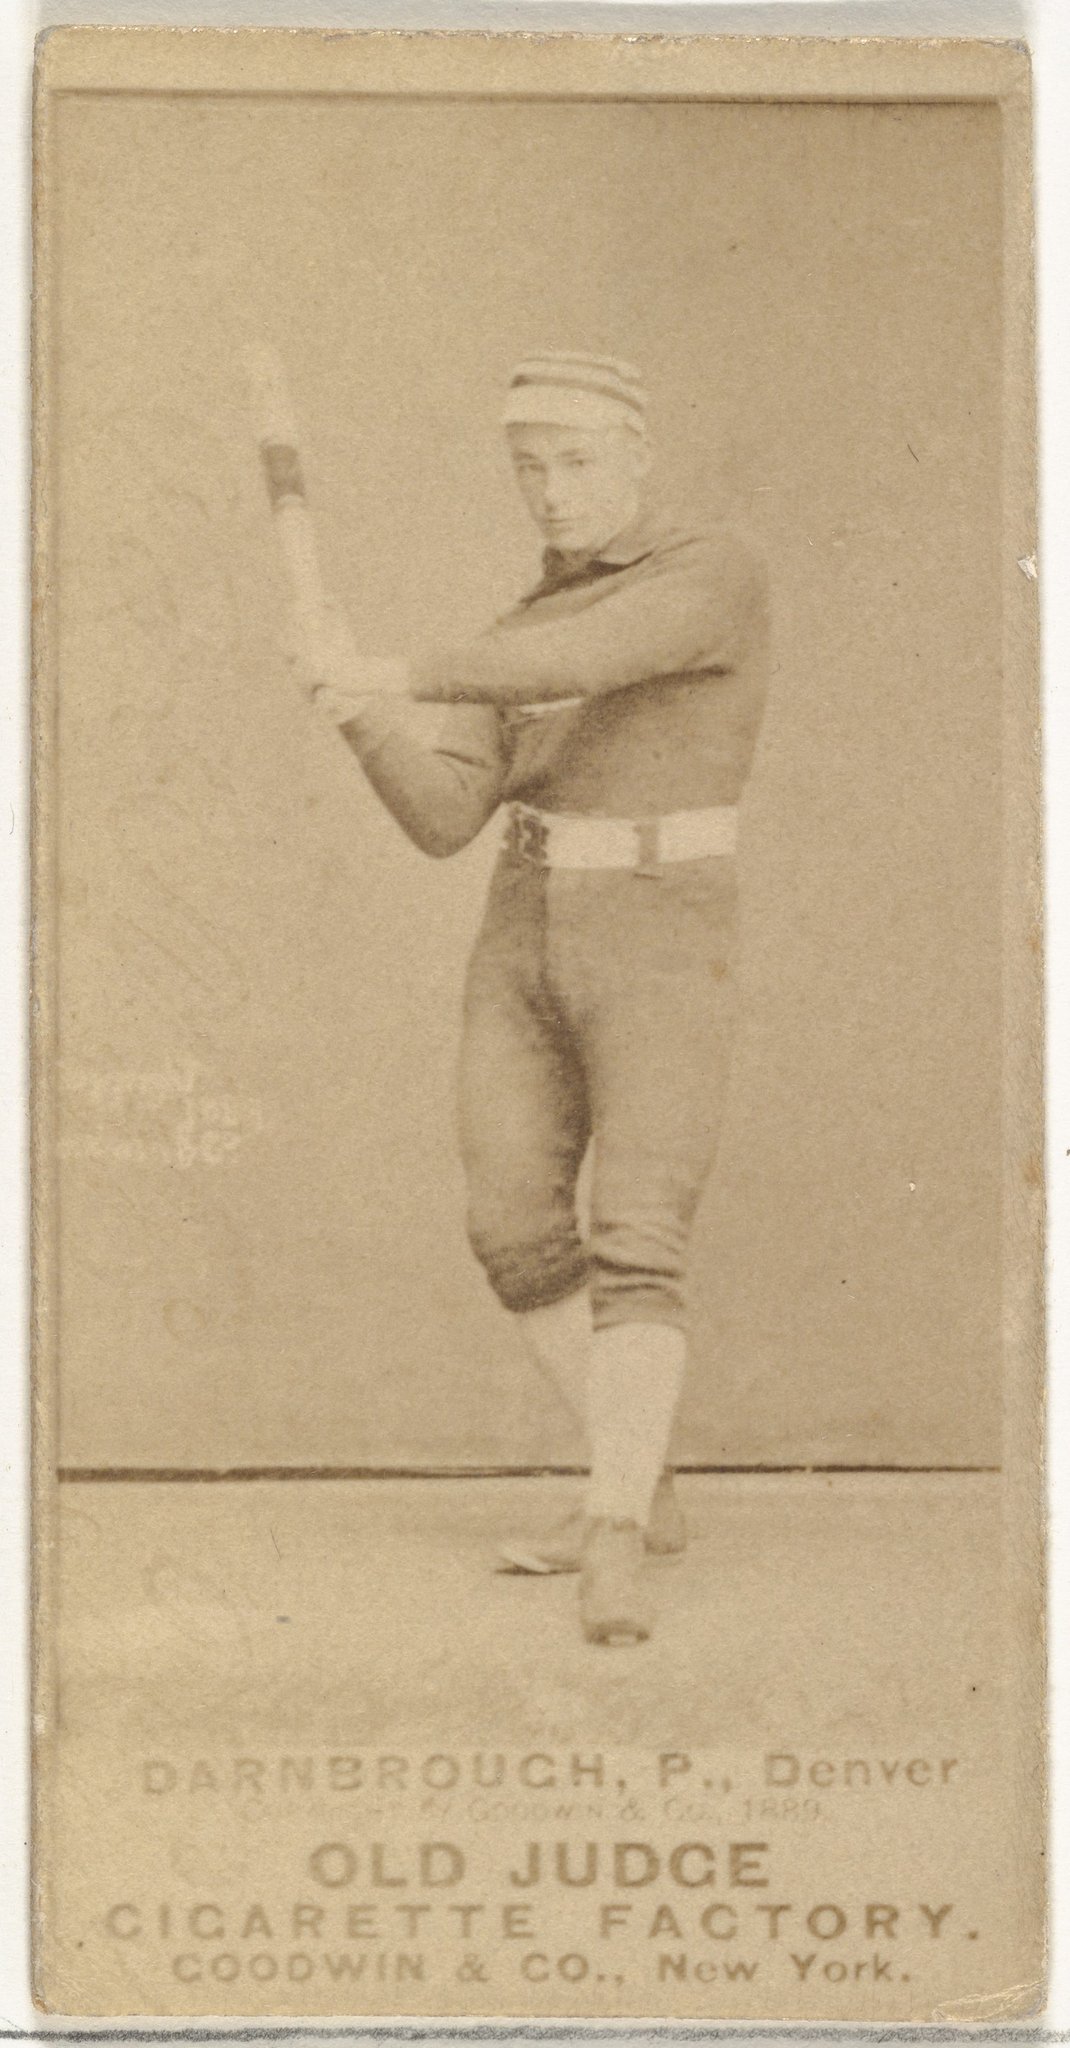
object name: baseball card, photograph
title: William Darnbrough, Pitcher, Denver, from the Old Judge series (N172) for Old Judge Cigarettes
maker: goodwin & company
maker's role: publisher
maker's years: 1850-1950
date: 1889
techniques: albumen silver print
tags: men,portraits,baseball,athletes